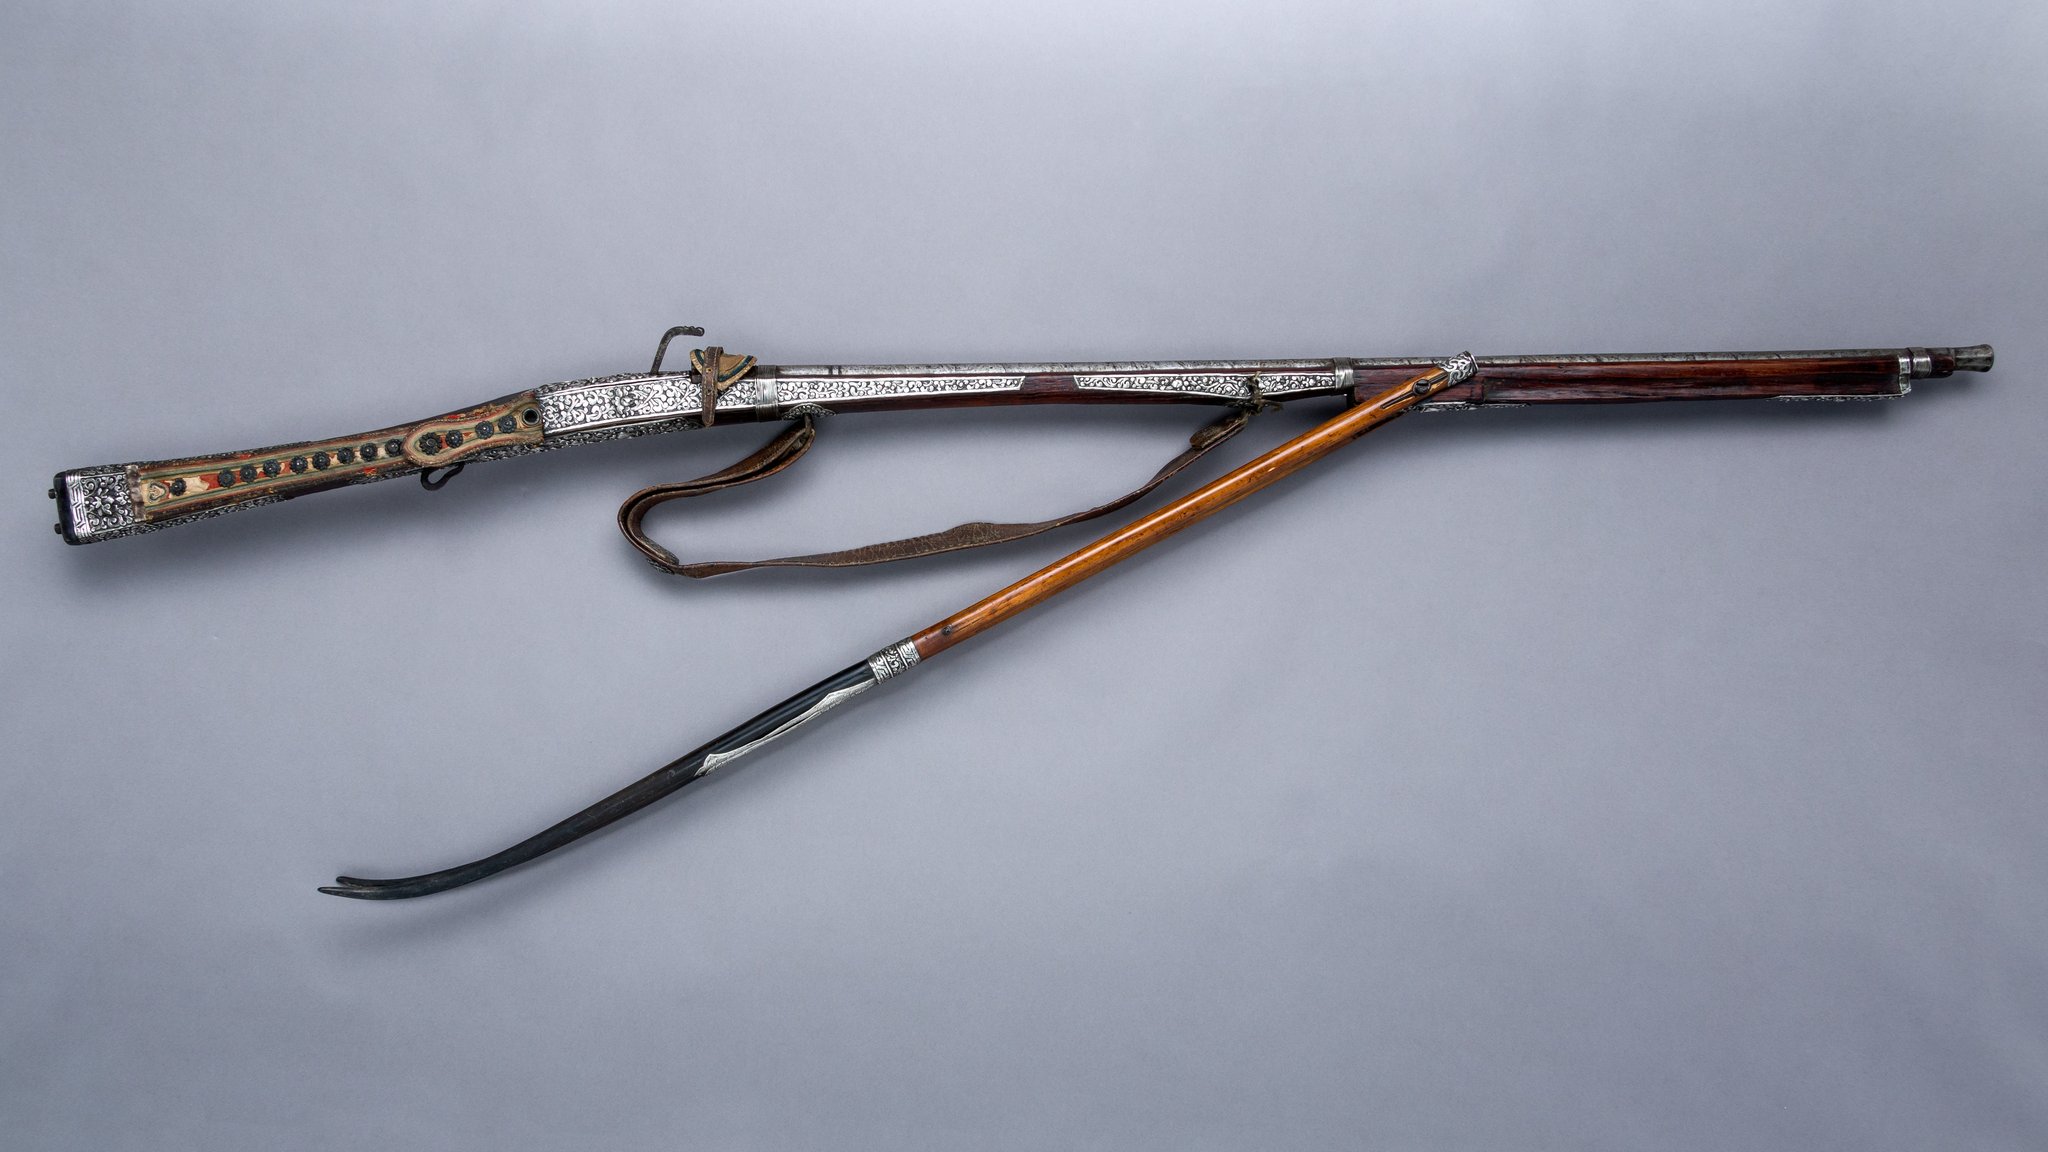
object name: matchlock musket me mda'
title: Matchlock Musket (me mda')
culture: tibetan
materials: horn, iron, leather, silver, textile, wood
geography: tibet